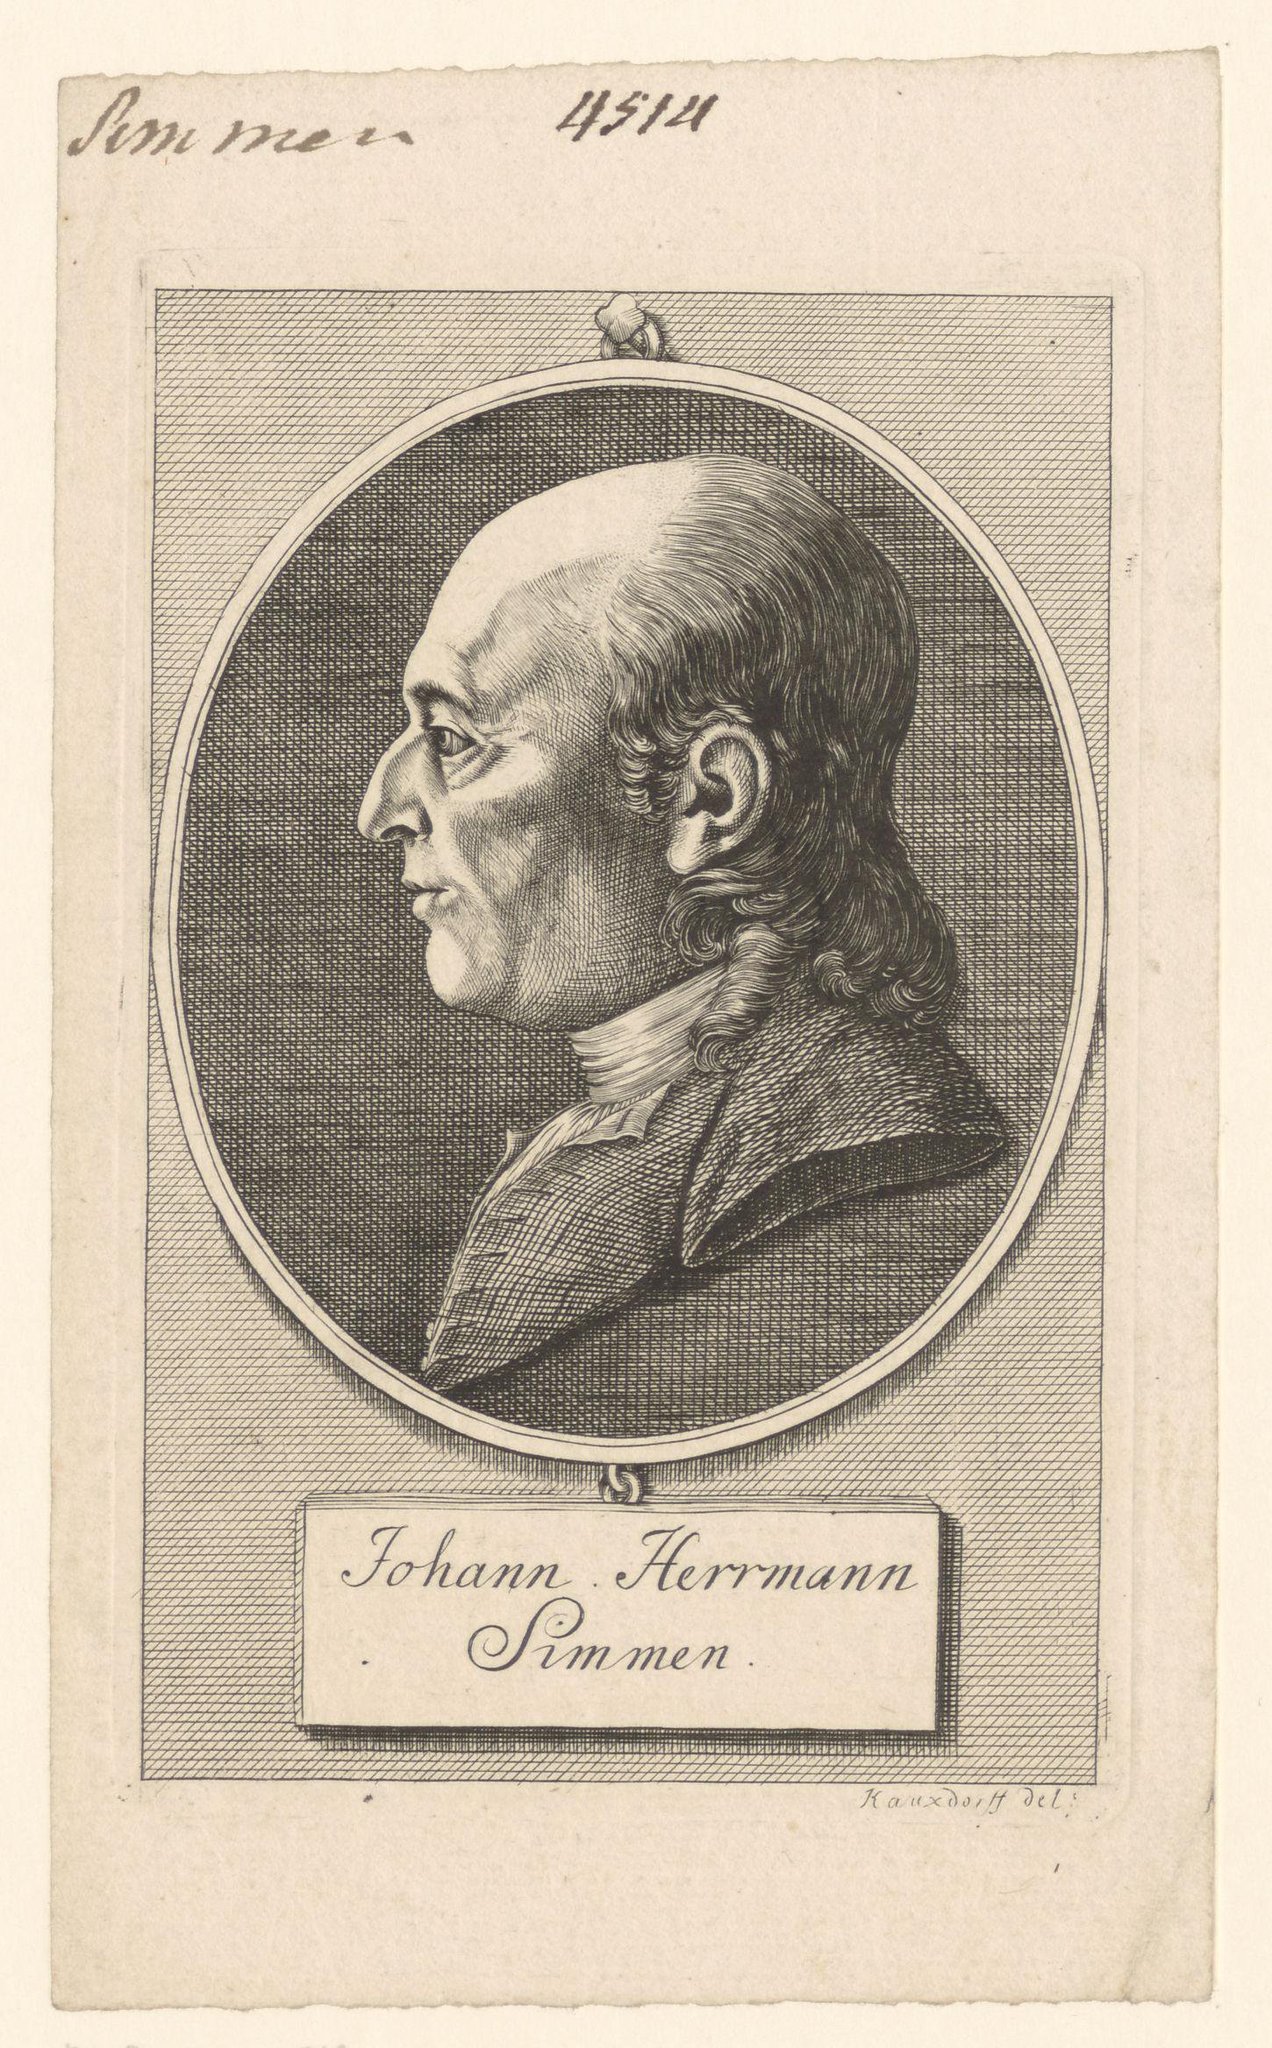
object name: print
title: Portret van Just Christian Friedrich Stuss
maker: kauxdorff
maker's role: draughtsman, print maker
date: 1782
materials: paper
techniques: engraving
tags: historical persons, portrait of a writer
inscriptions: collector's mark: Lugt 2228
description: Prent gebruikt in: Simmen, Johann Herrmann. Ein Beytrag zur Physiognomik und Menschenkenntnis. Gotha: Ettinger, 1782.